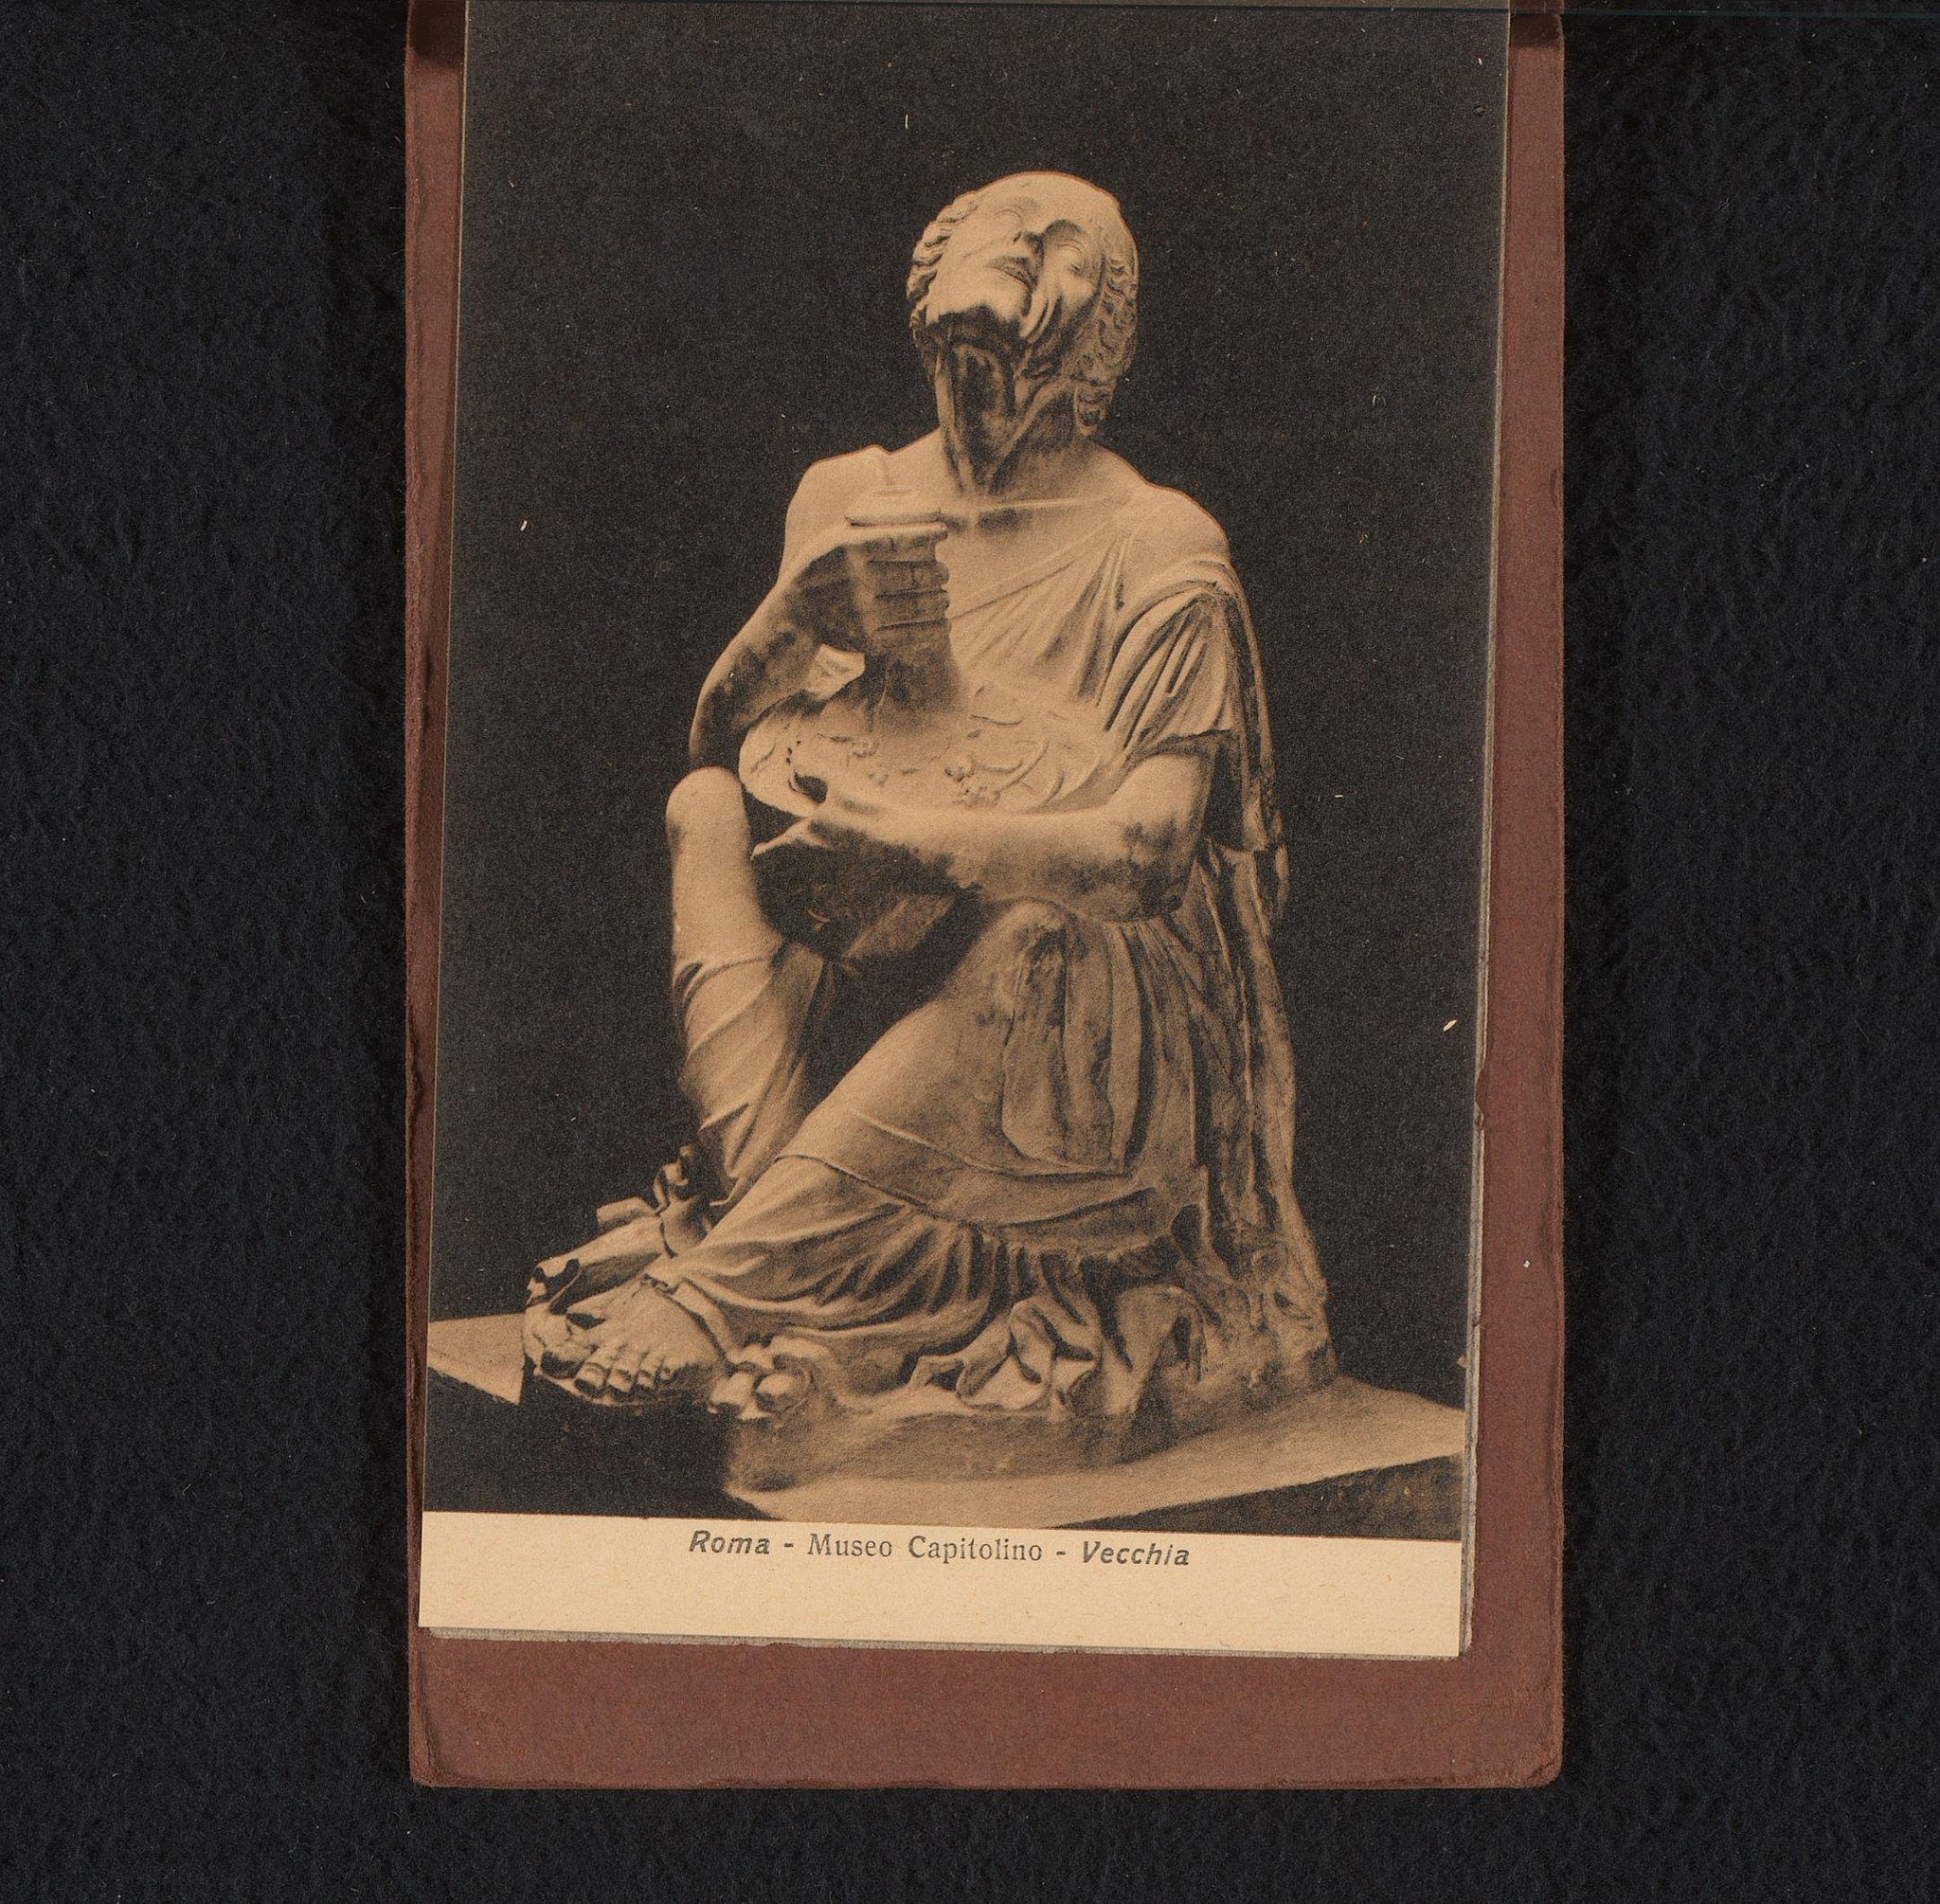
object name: ansichtkaart, prentbriefkaart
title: Roma - Museo Capitolino - Vecchia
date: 1905-1930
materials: cardboard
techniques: photograph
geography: terni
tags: statues, paintings, etc. ~ objects of worship in roman religion, permanent exhibition, museum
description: Prentbriefkaart maakt deel uit van een album.